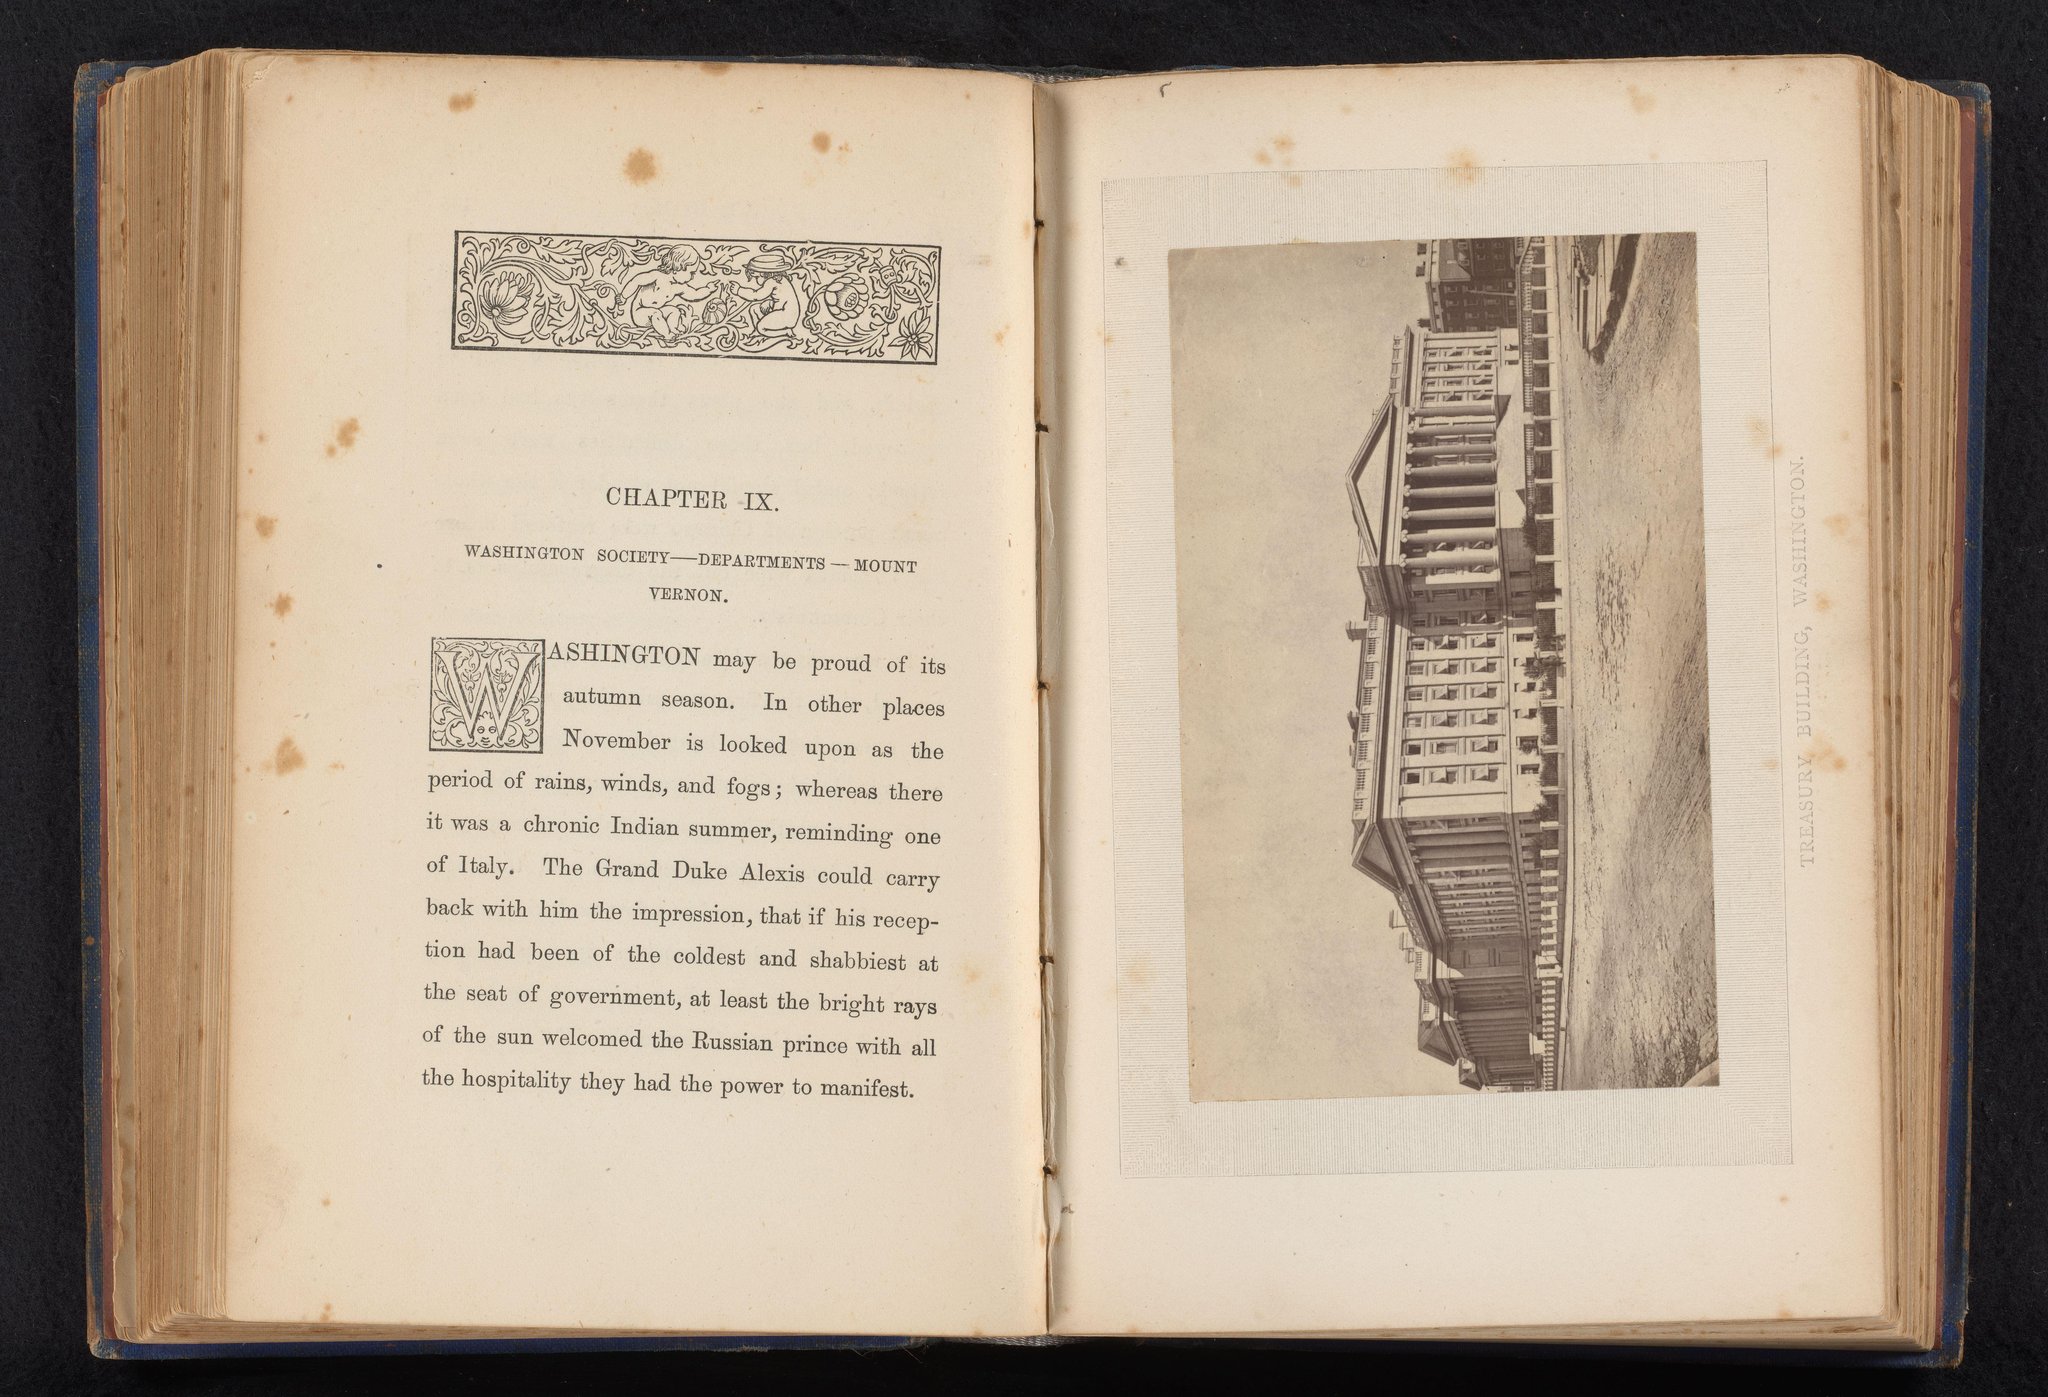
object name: photograph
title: Exterieur van de Treasury Building in Washington D.C.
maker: Anonymous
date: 1862-1872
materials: paper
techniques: albumen print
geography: washington d.c.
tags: treasurer, exterior ~ representation of a building